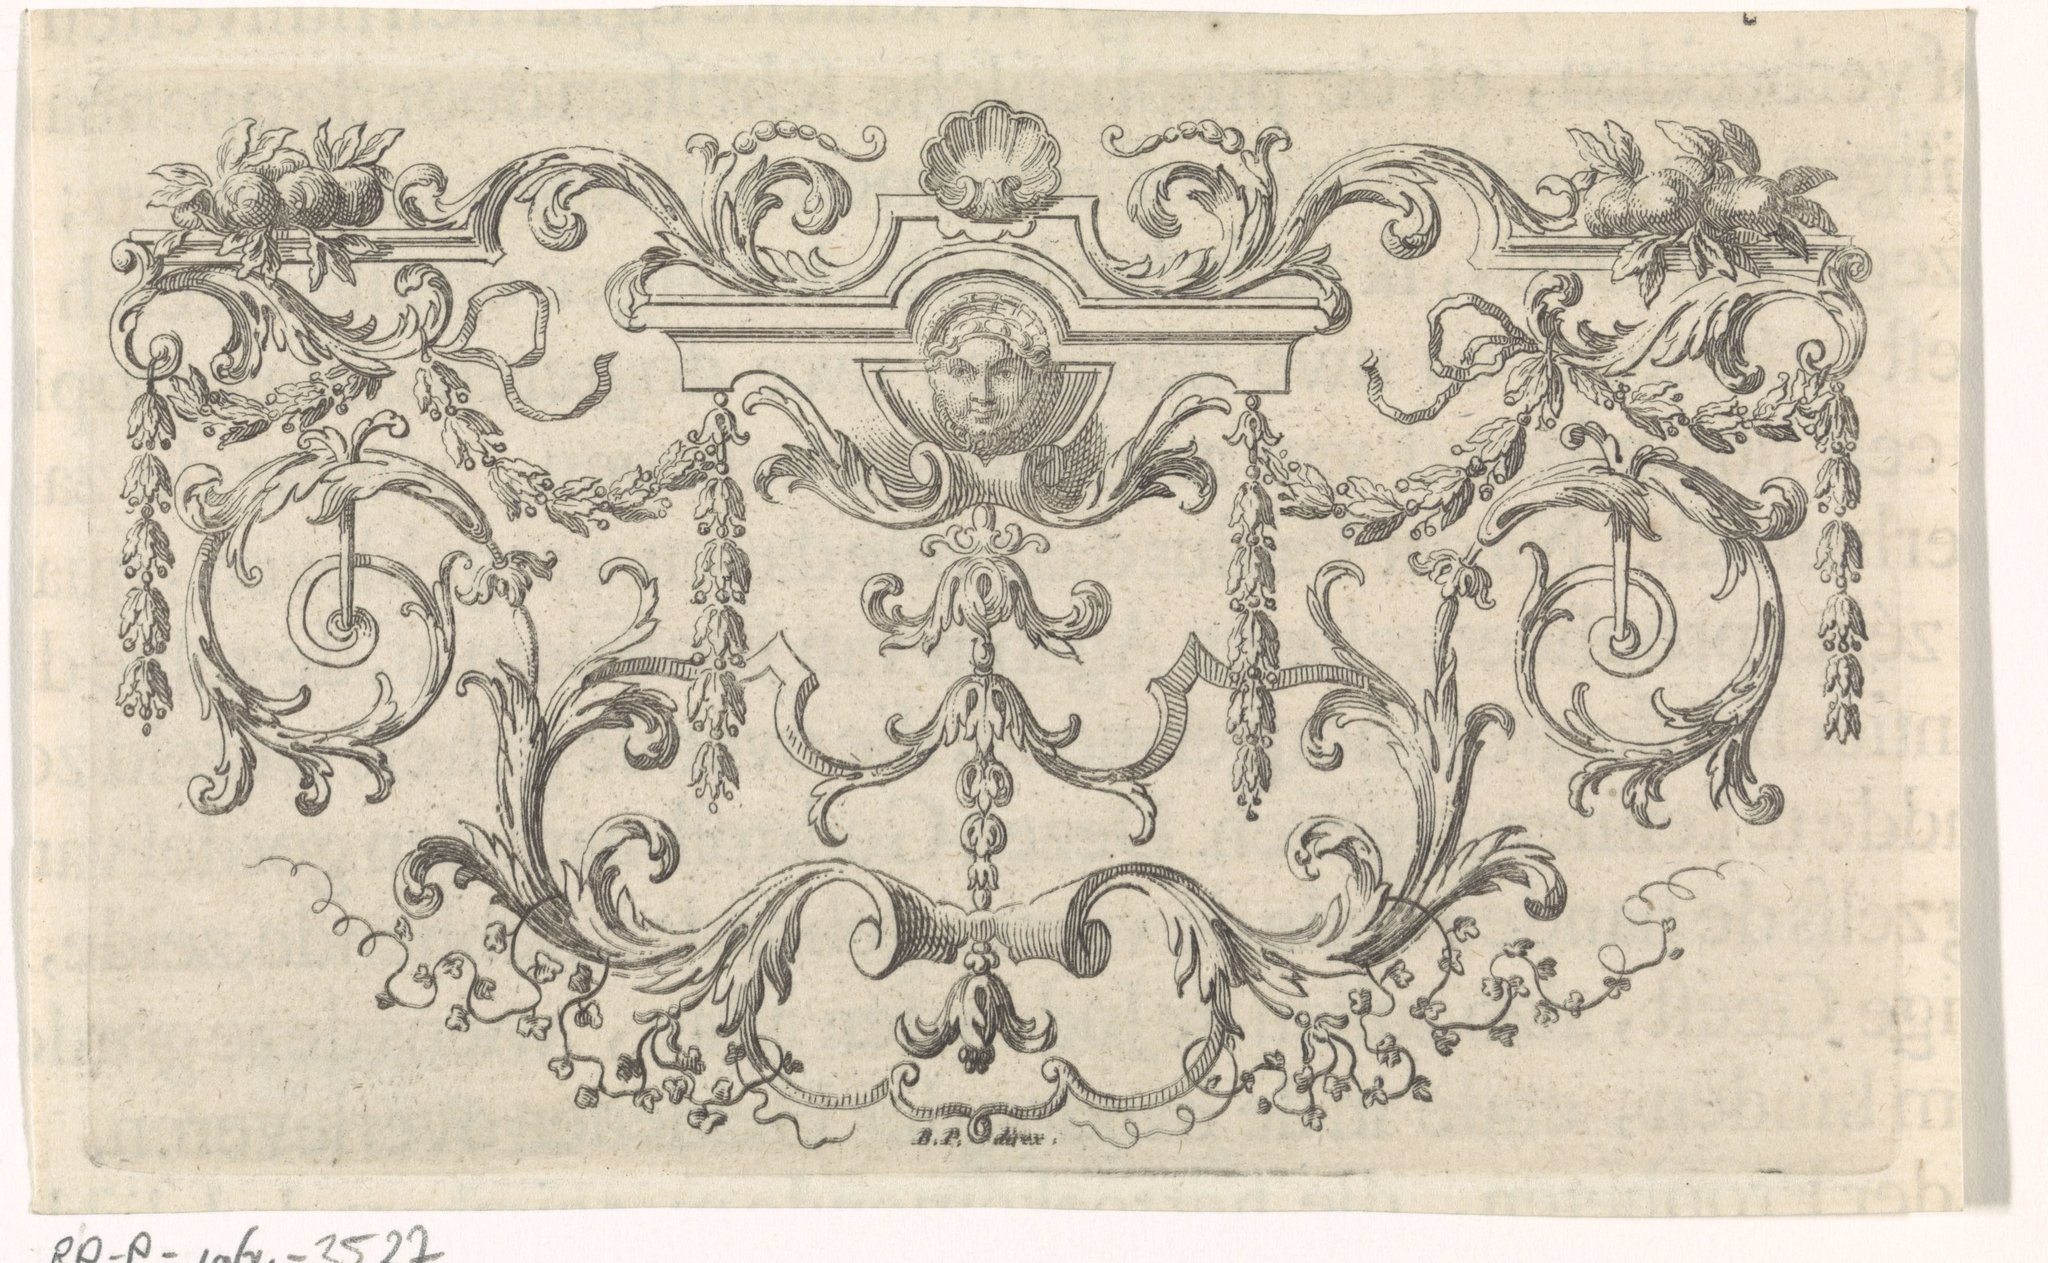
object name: print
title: Ornament met een mascaron, guirlandes, bladranken en schelp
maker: bernard picart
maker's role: draughtsman, print maker, publisher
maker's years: 1673-1733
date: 1683-1733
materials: paper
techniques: engraving, etching, letterpress printing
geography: amsterdam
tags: scallop, shell ~ ornament, mask, mascaron ~ ornament, ornament ~ festoon, garland, foliage, tendrils, branches ~ ornament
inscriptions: collector's mark: Lugt 2228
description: Prent oorspronkelijk bedoeld voor: Figures de la Bible. Amsterdam, Bernard Picart, 1720. Prent ook gebruikt in: Taferelen der voornaamste geschiedenissen van het Oude en Nieuwe Testament (...) door de vermaarde kunstenaars Hoet, Houbraken, en Picart getekent (...) en met beschrijvingen uitgebreid. Den Haag: Pieter de Hondt, 1728. Prent kan mogelijk ook zijn gebruikt in andere bijbels.